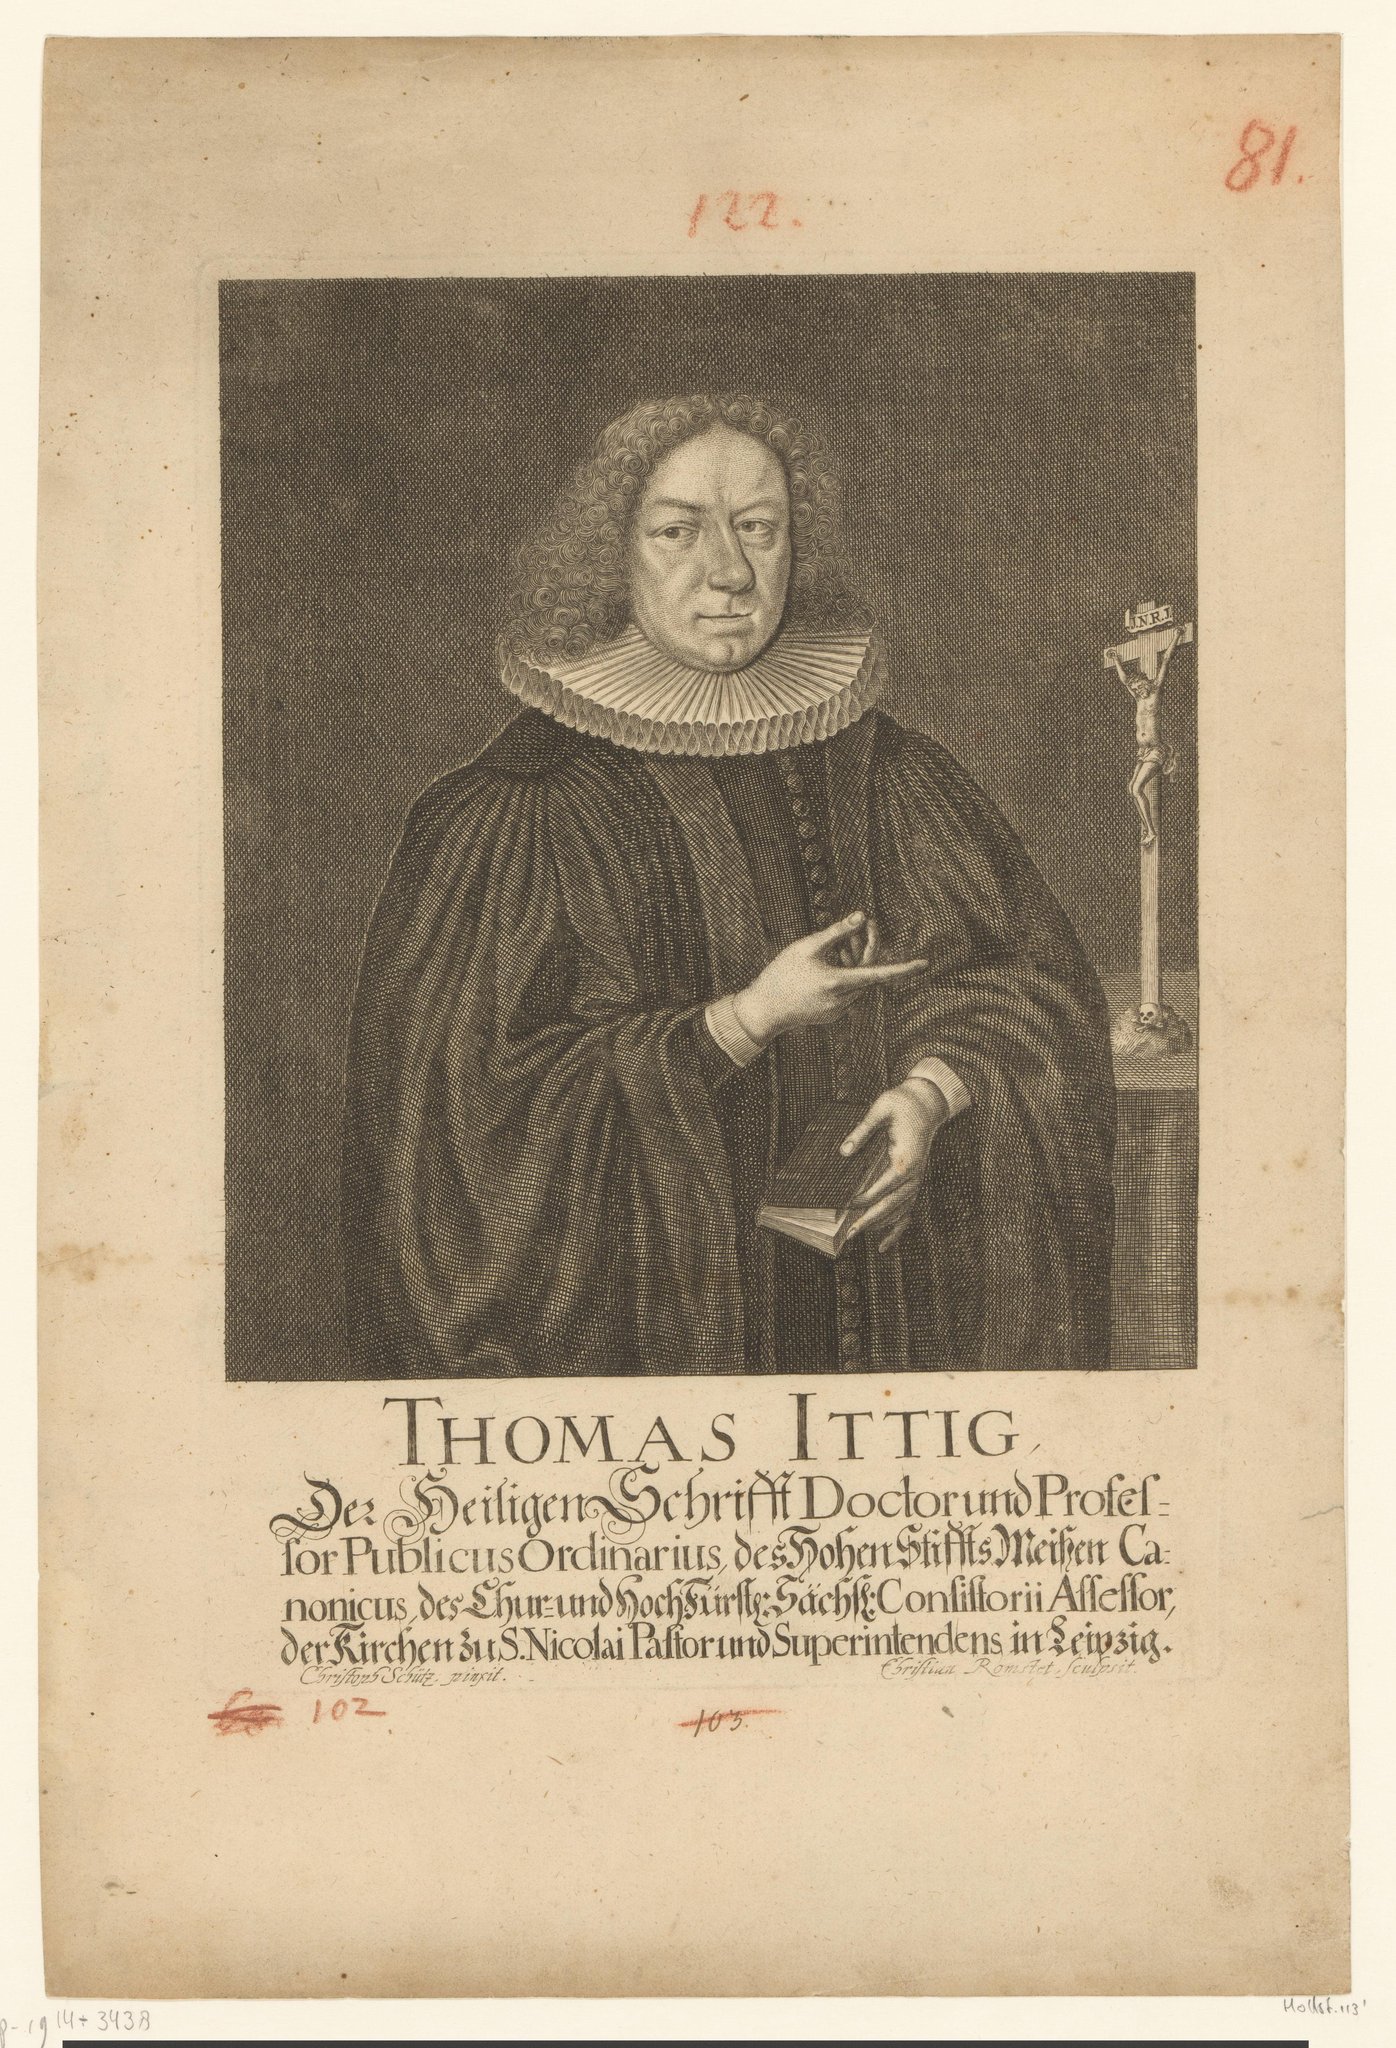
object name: print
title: Portret van Thomas Ittig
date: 1665-1721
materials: paper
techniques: engraving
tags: thomas ittig, theologian, historical persons, book, crucifix ~ personal devotion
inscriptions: collector's mark: Lugt 2228, number